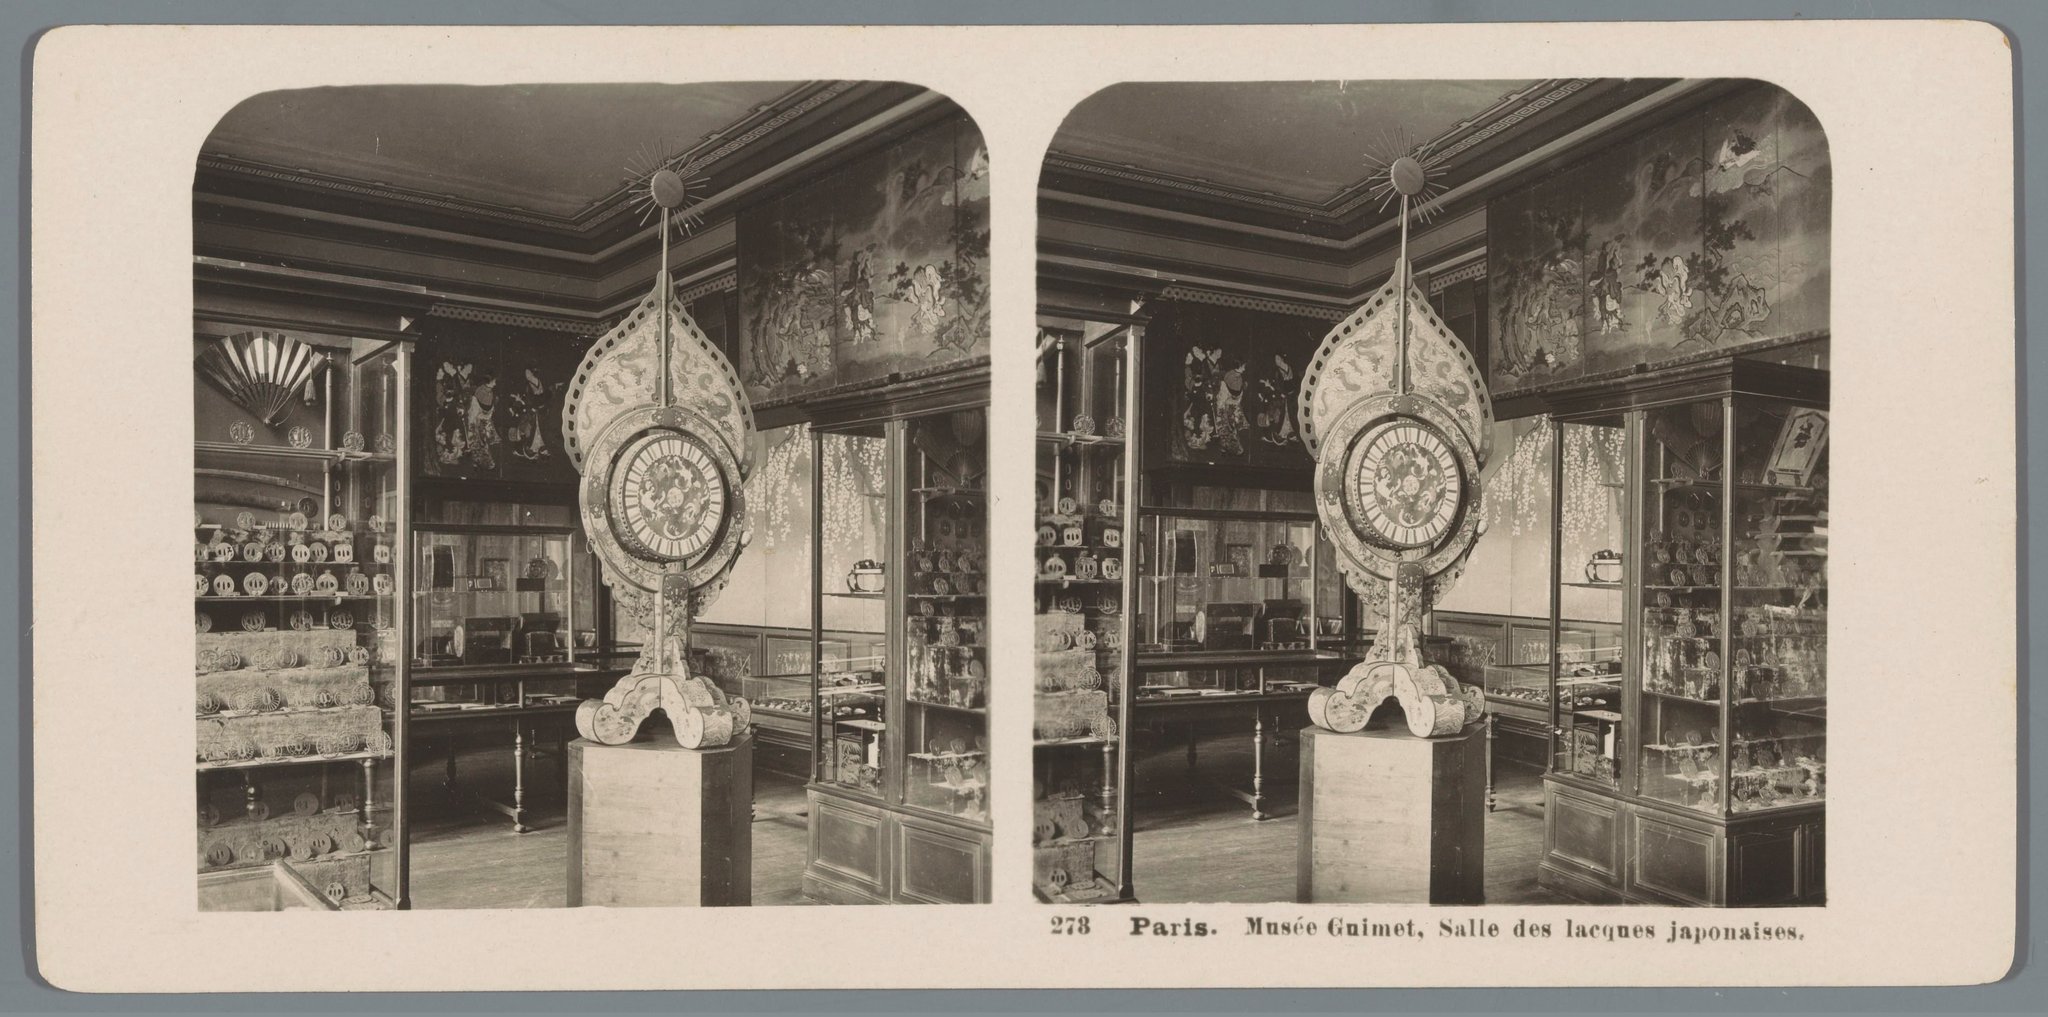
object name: stereograph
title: Paris. Musée Guimet, salle des lacques japonaises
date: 1903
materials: cardboard, photographic support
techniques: gelatin silver print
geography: musée guimet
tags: lacquering ~ applied arts, permanent exhibition, museum, exhibition ~ art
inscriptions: inscription: ‘Neue Photographische Gesellschaft A.-G. Steglitz-Berlin 1903.’, number: ‘278’